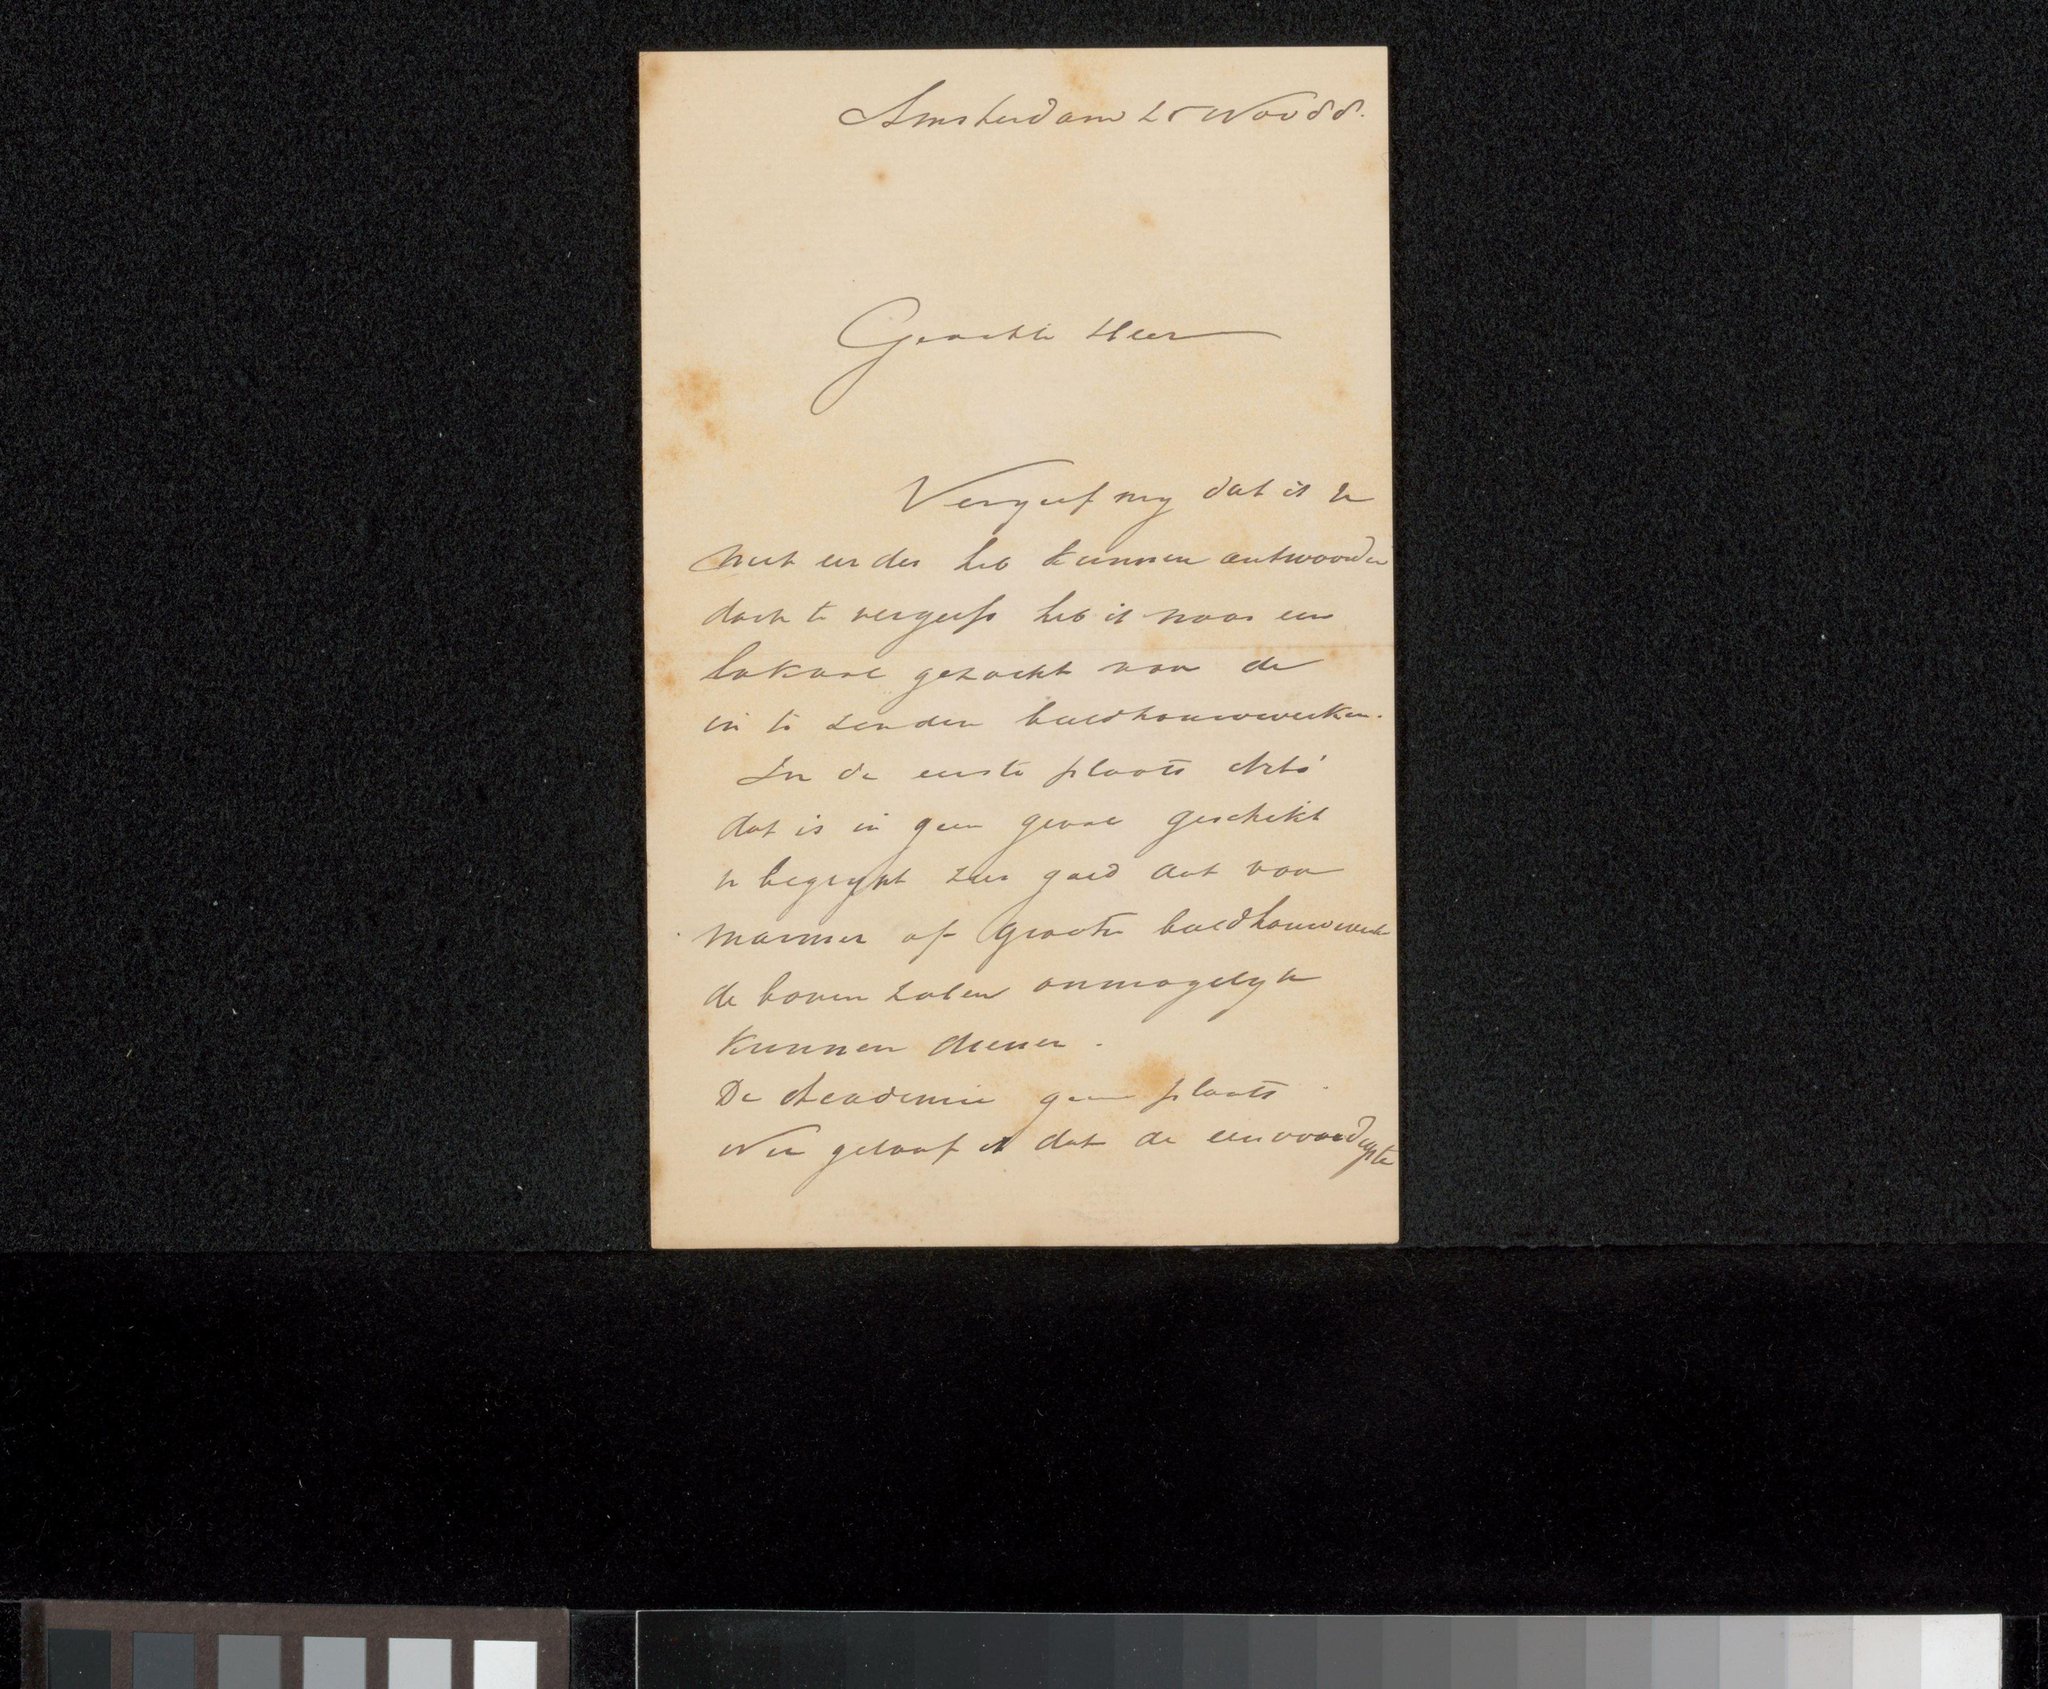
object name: letter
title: Brief aan Philip Zilcken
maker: bart van hove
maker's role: sculptor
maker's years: 1850-1914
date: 1888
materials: ink, paper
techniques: pen, writing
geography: amsterdam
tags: the hague, painter, draughtsman, philip zilcken, sculpture, brussels, paris, amsterdam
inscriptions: collector's mark: ‘RPK’